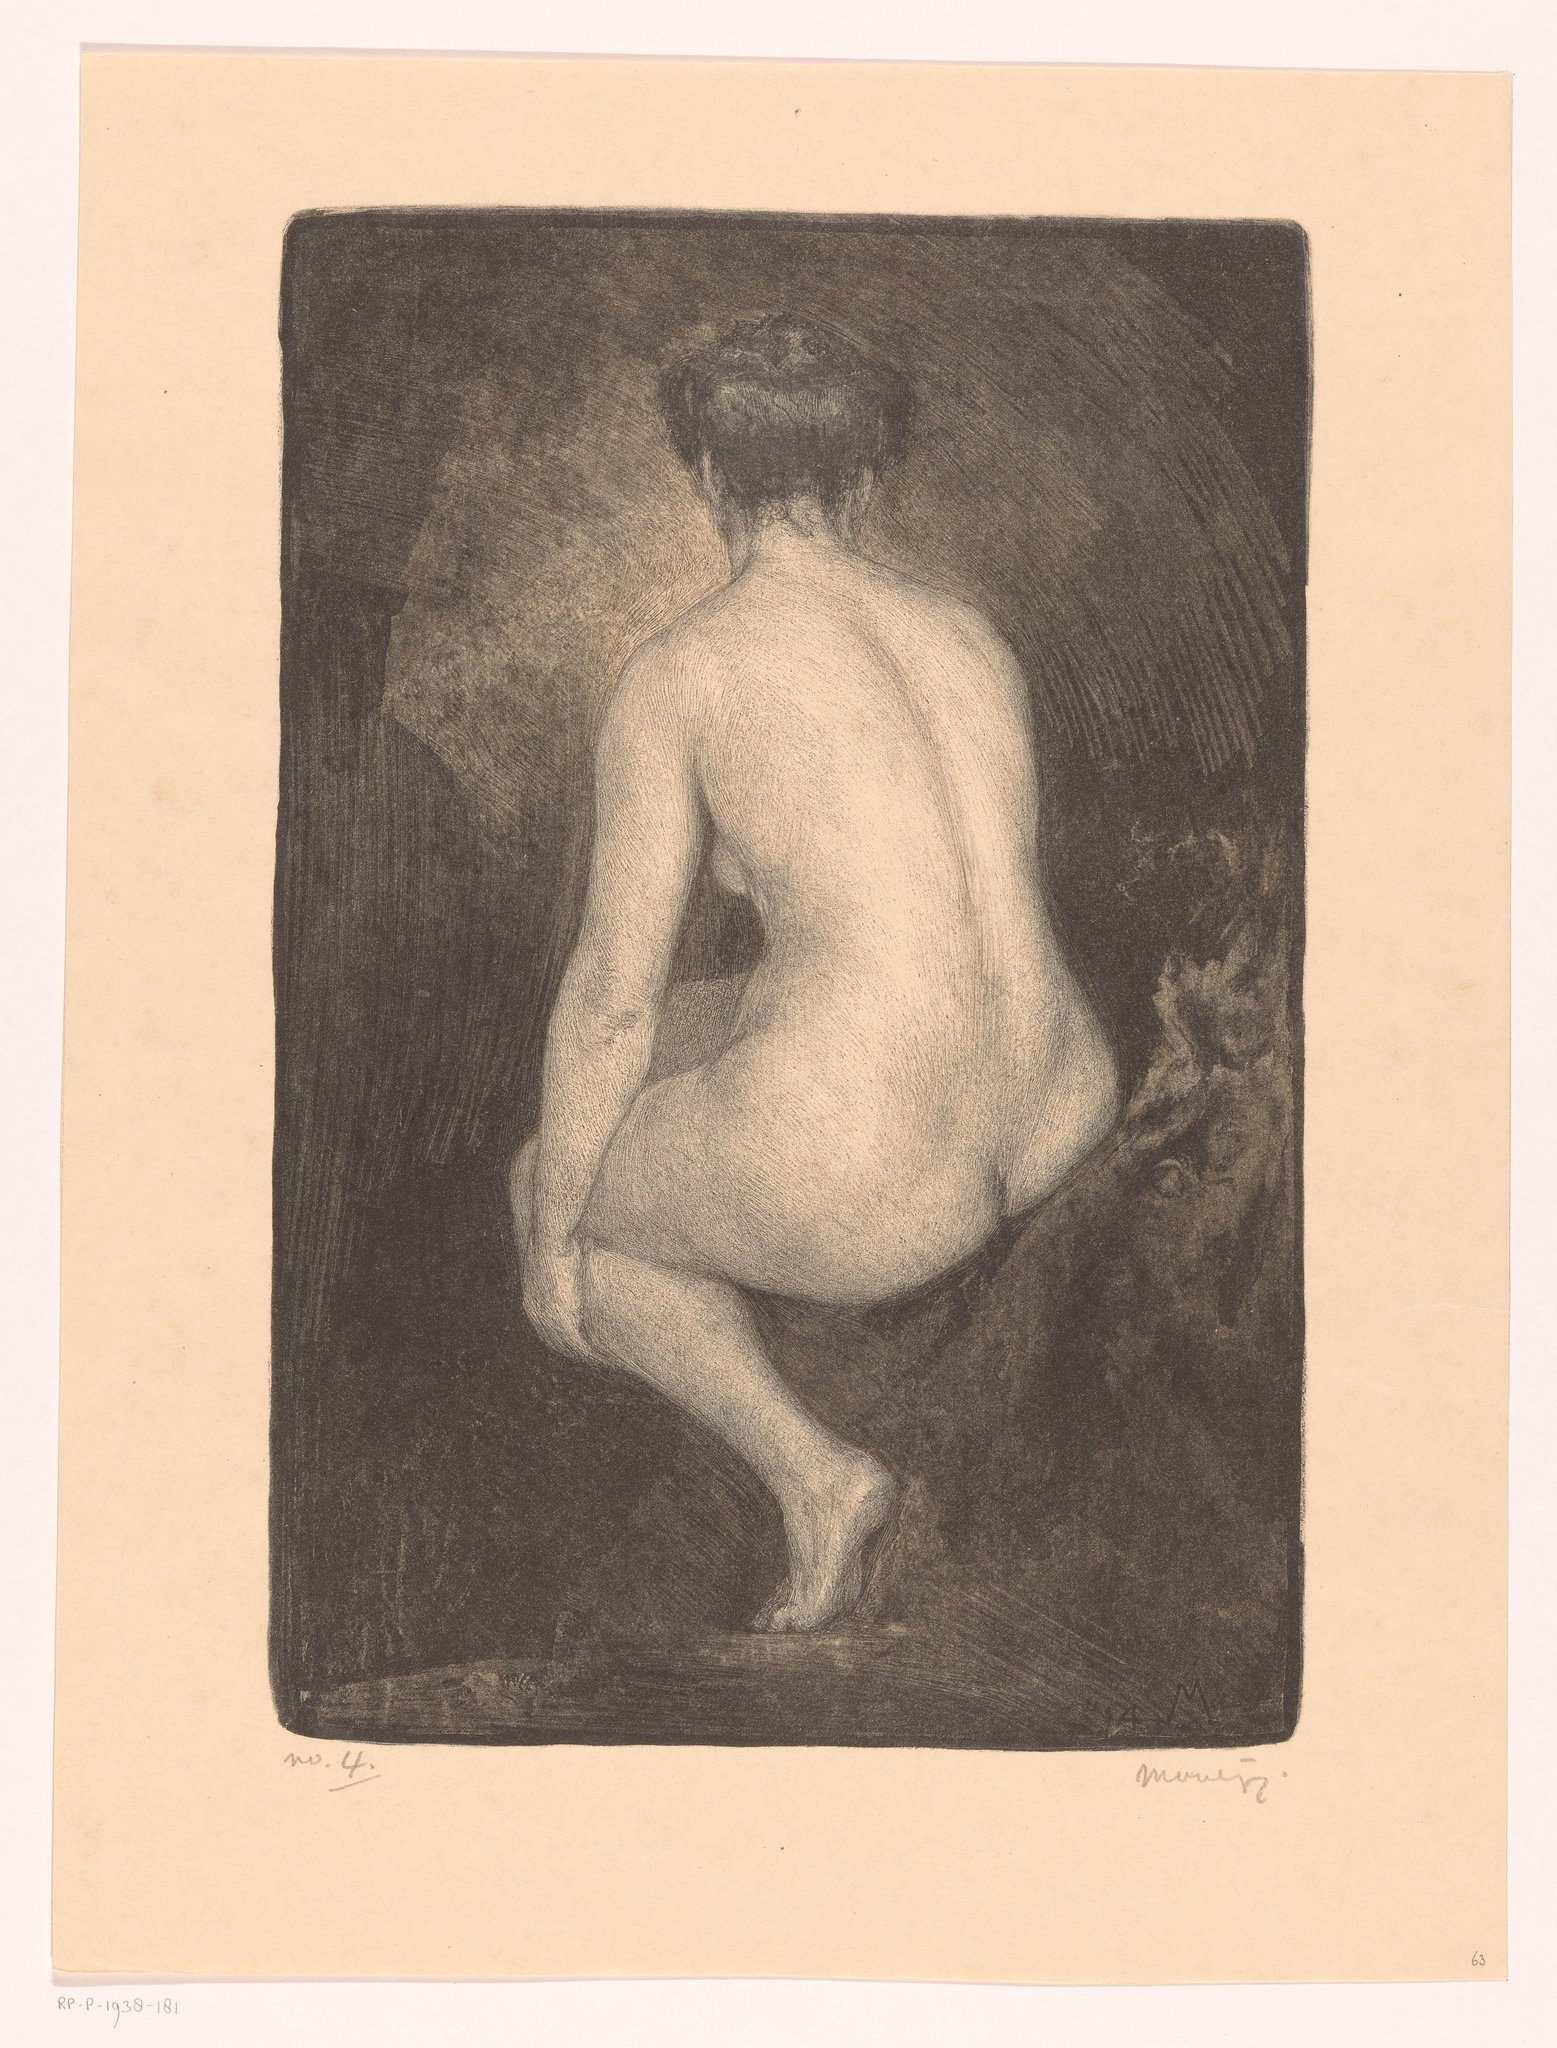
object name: print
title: Zittende naakte vrouw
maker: simon moulijn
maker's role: draughtsman, print maker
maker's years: 1866-1948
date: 1914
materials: paper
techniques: lithograph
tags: sitting figure - aa - female human figure, woman (showing herself) undressed, quasi-nude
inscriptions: collector's mark: Lugt 2228, collector's mark: Lugt 2760, number: ‘no. 4.’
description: Een naakte zittende vrouw, op de rug gezien voor een donkere achtergrond.